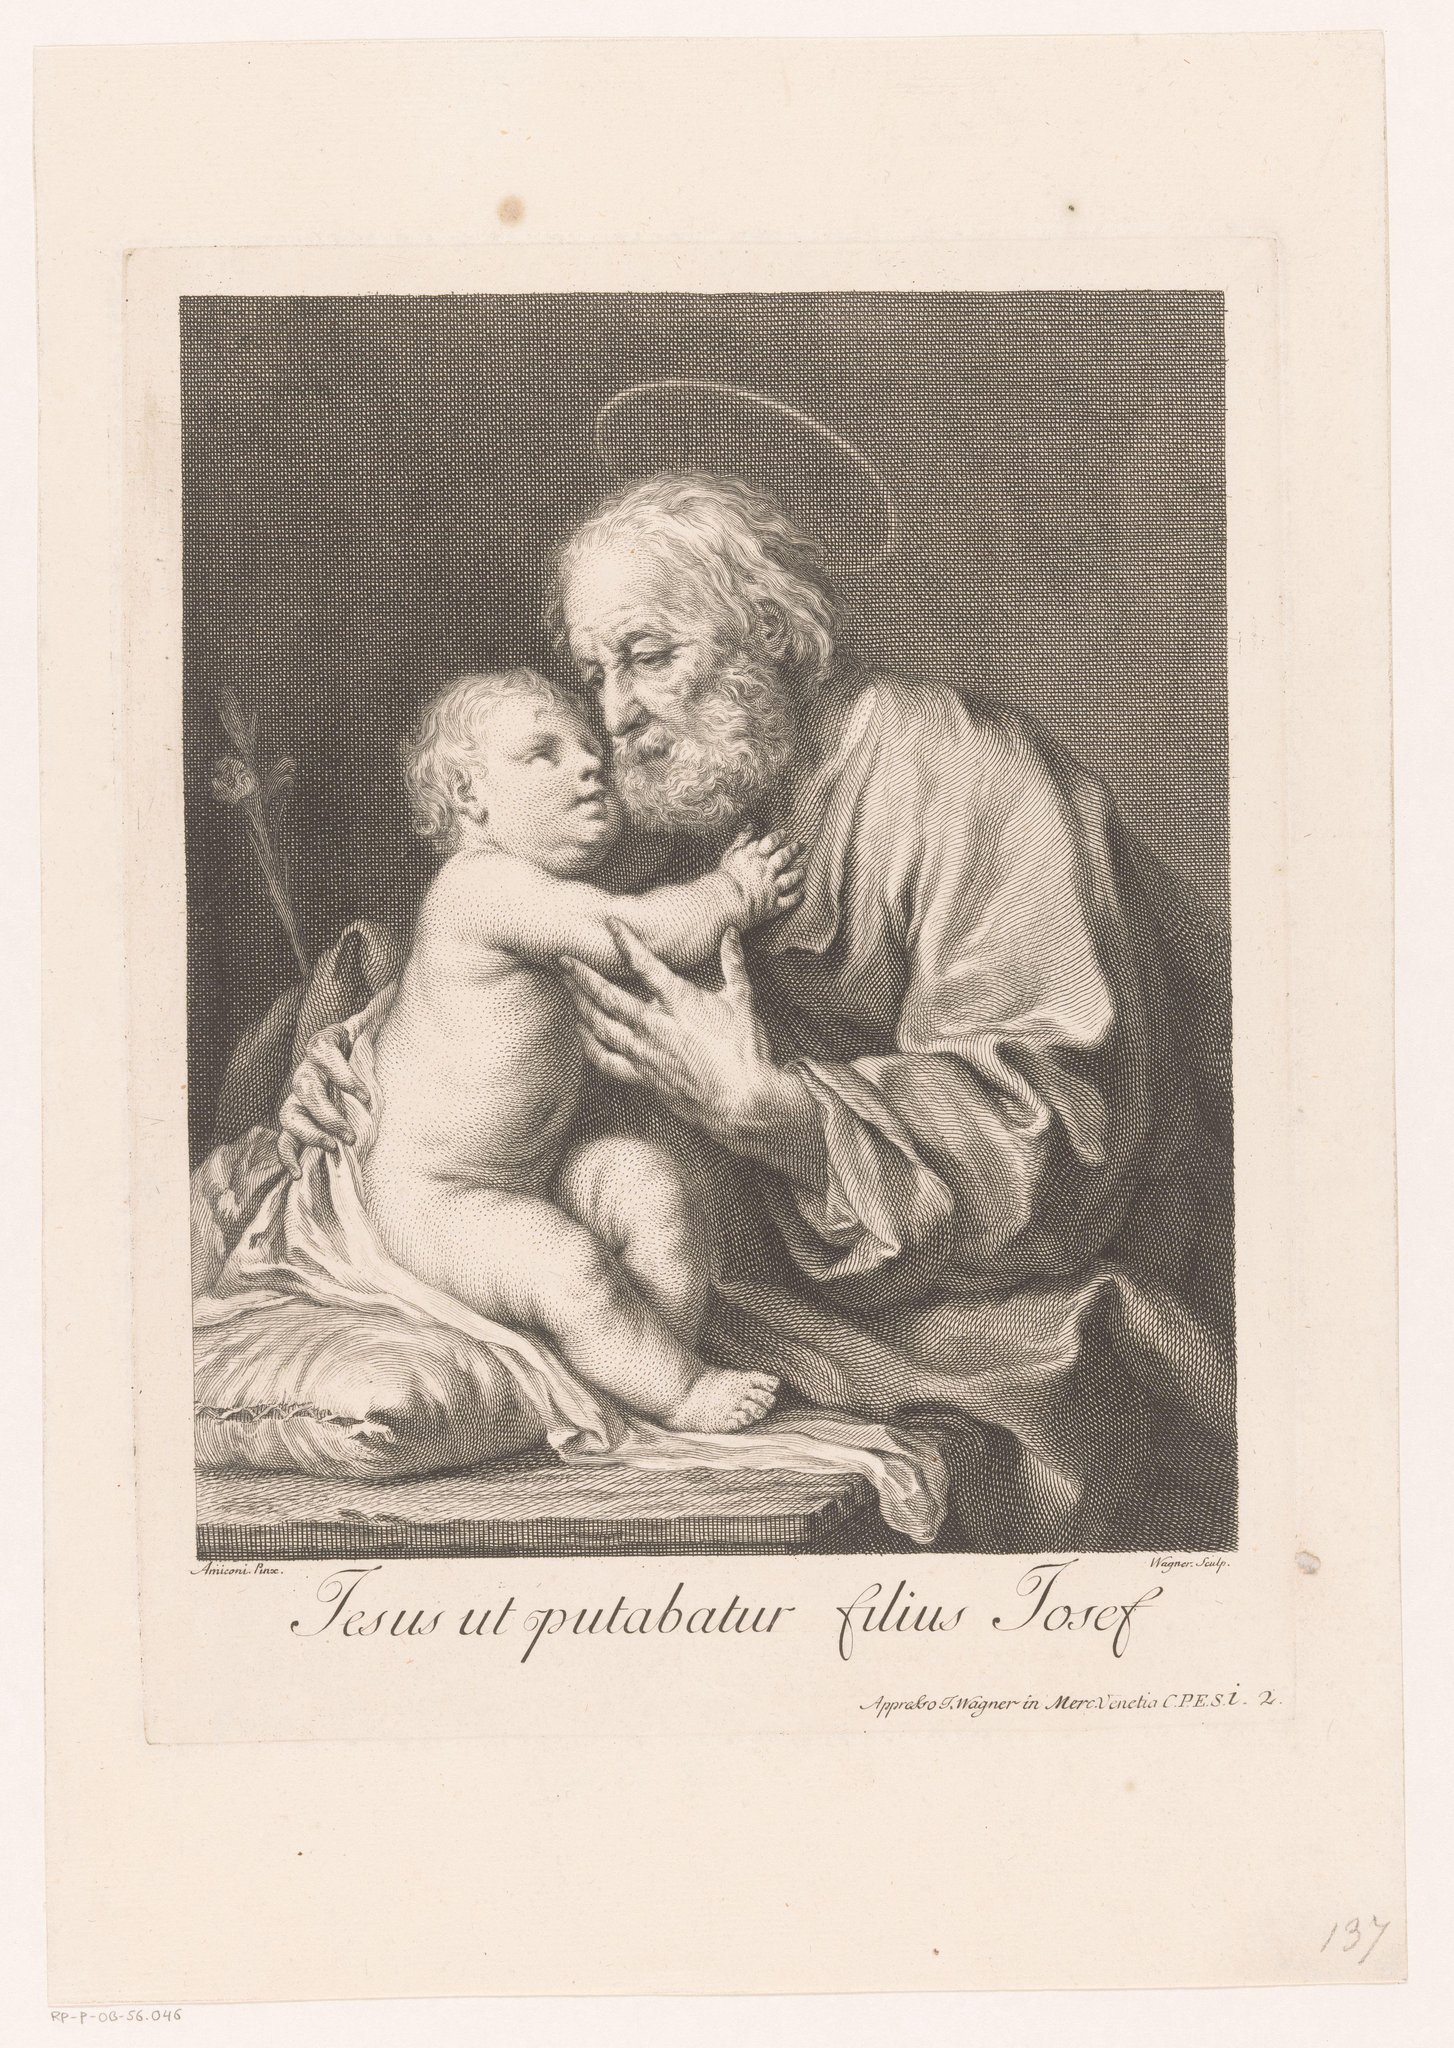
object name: print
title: Jozef en het Christuskind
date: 1739-1780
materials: paper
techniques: etching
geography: venice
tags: joseph and the christ-child ~ daily life in nazareth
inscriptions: collector's mark: Lugt 2228